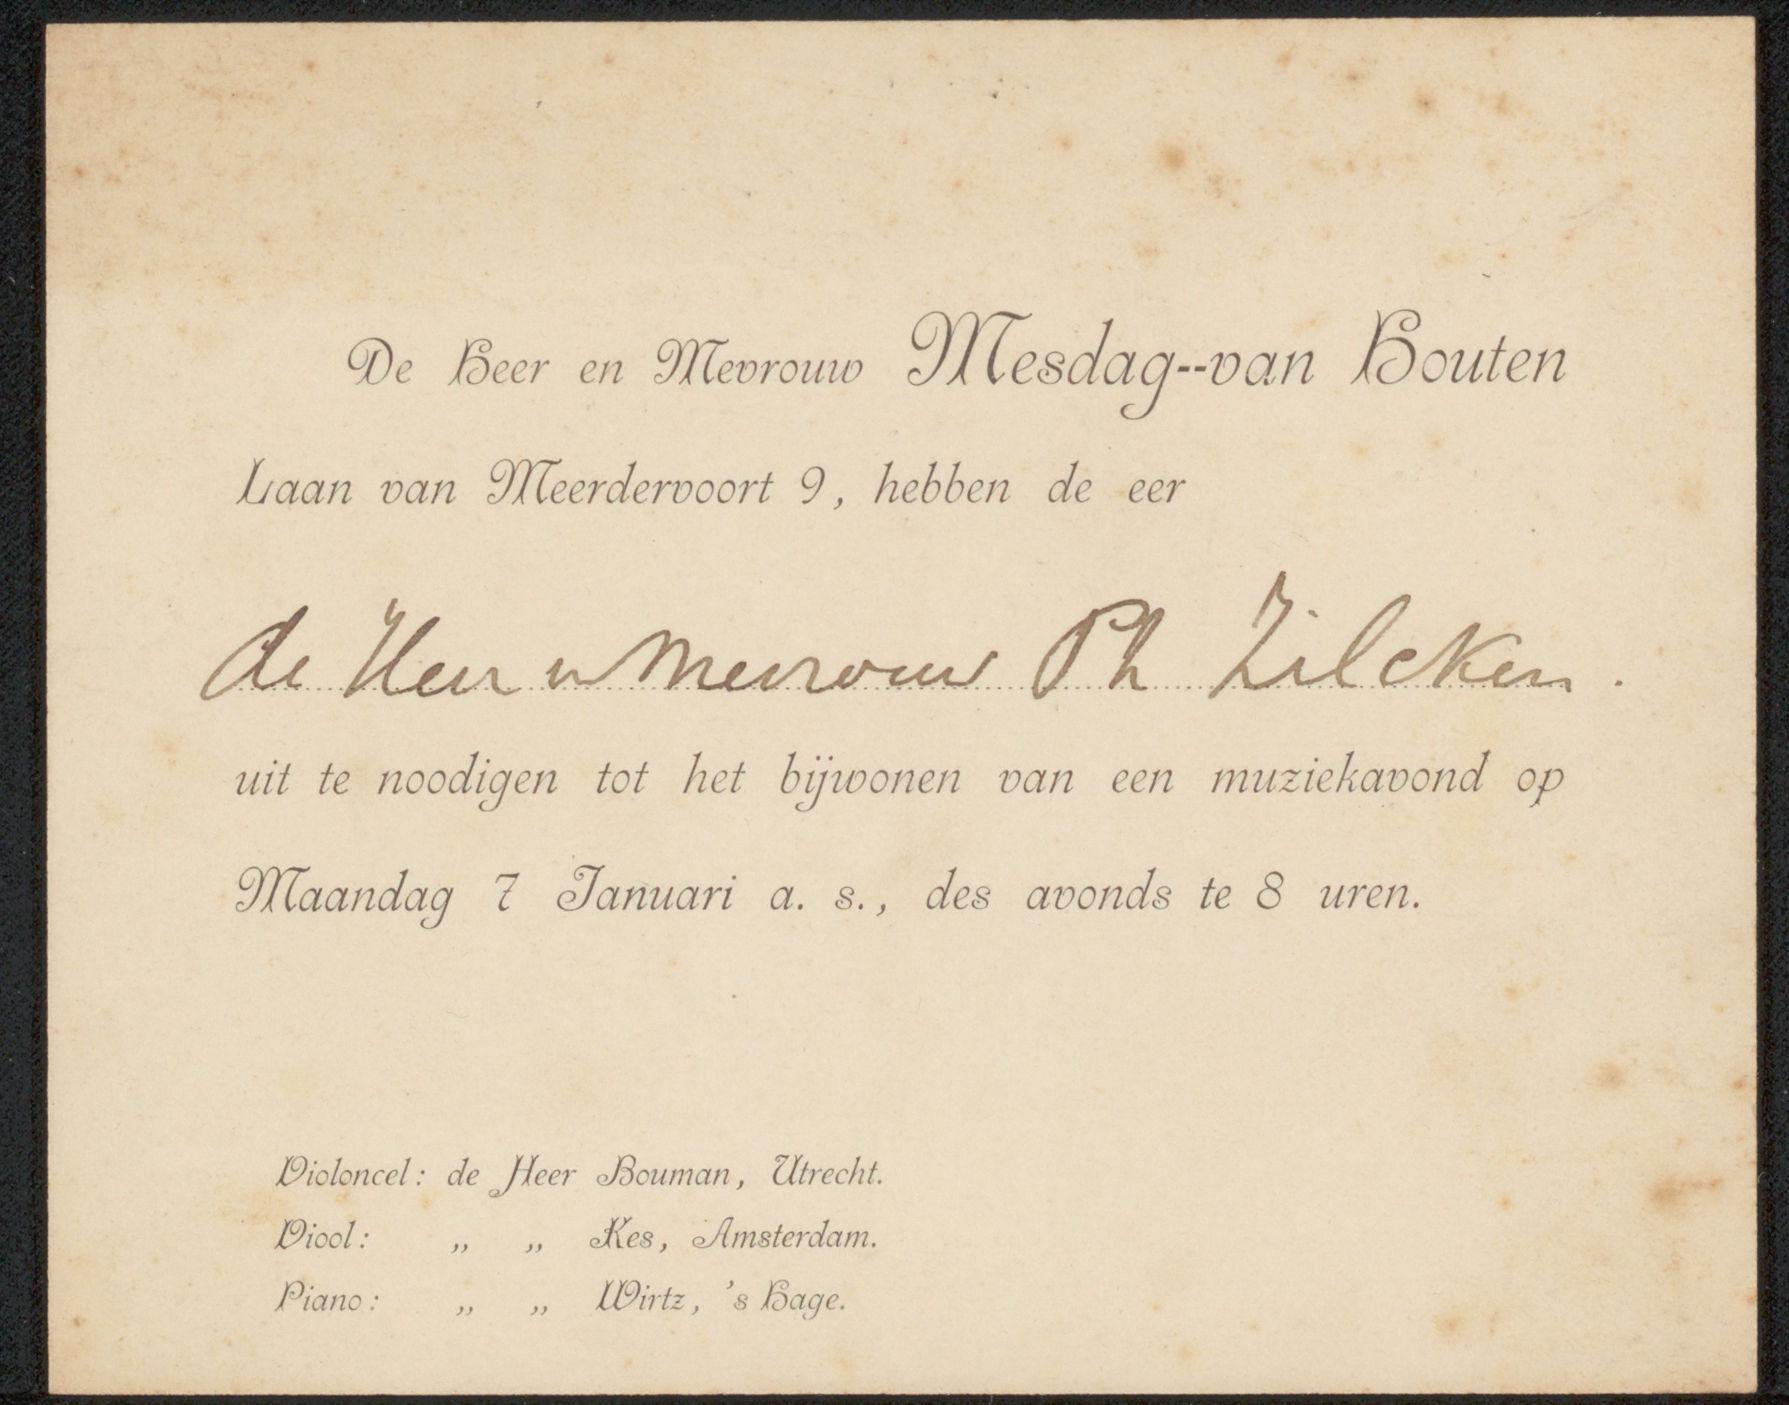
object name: invitation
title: Uitnodiging aan Philip Zilcken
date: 1856-1909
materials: cardboard, ink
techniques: pen, printing, writing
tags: dordrecht, philip zilcken, music